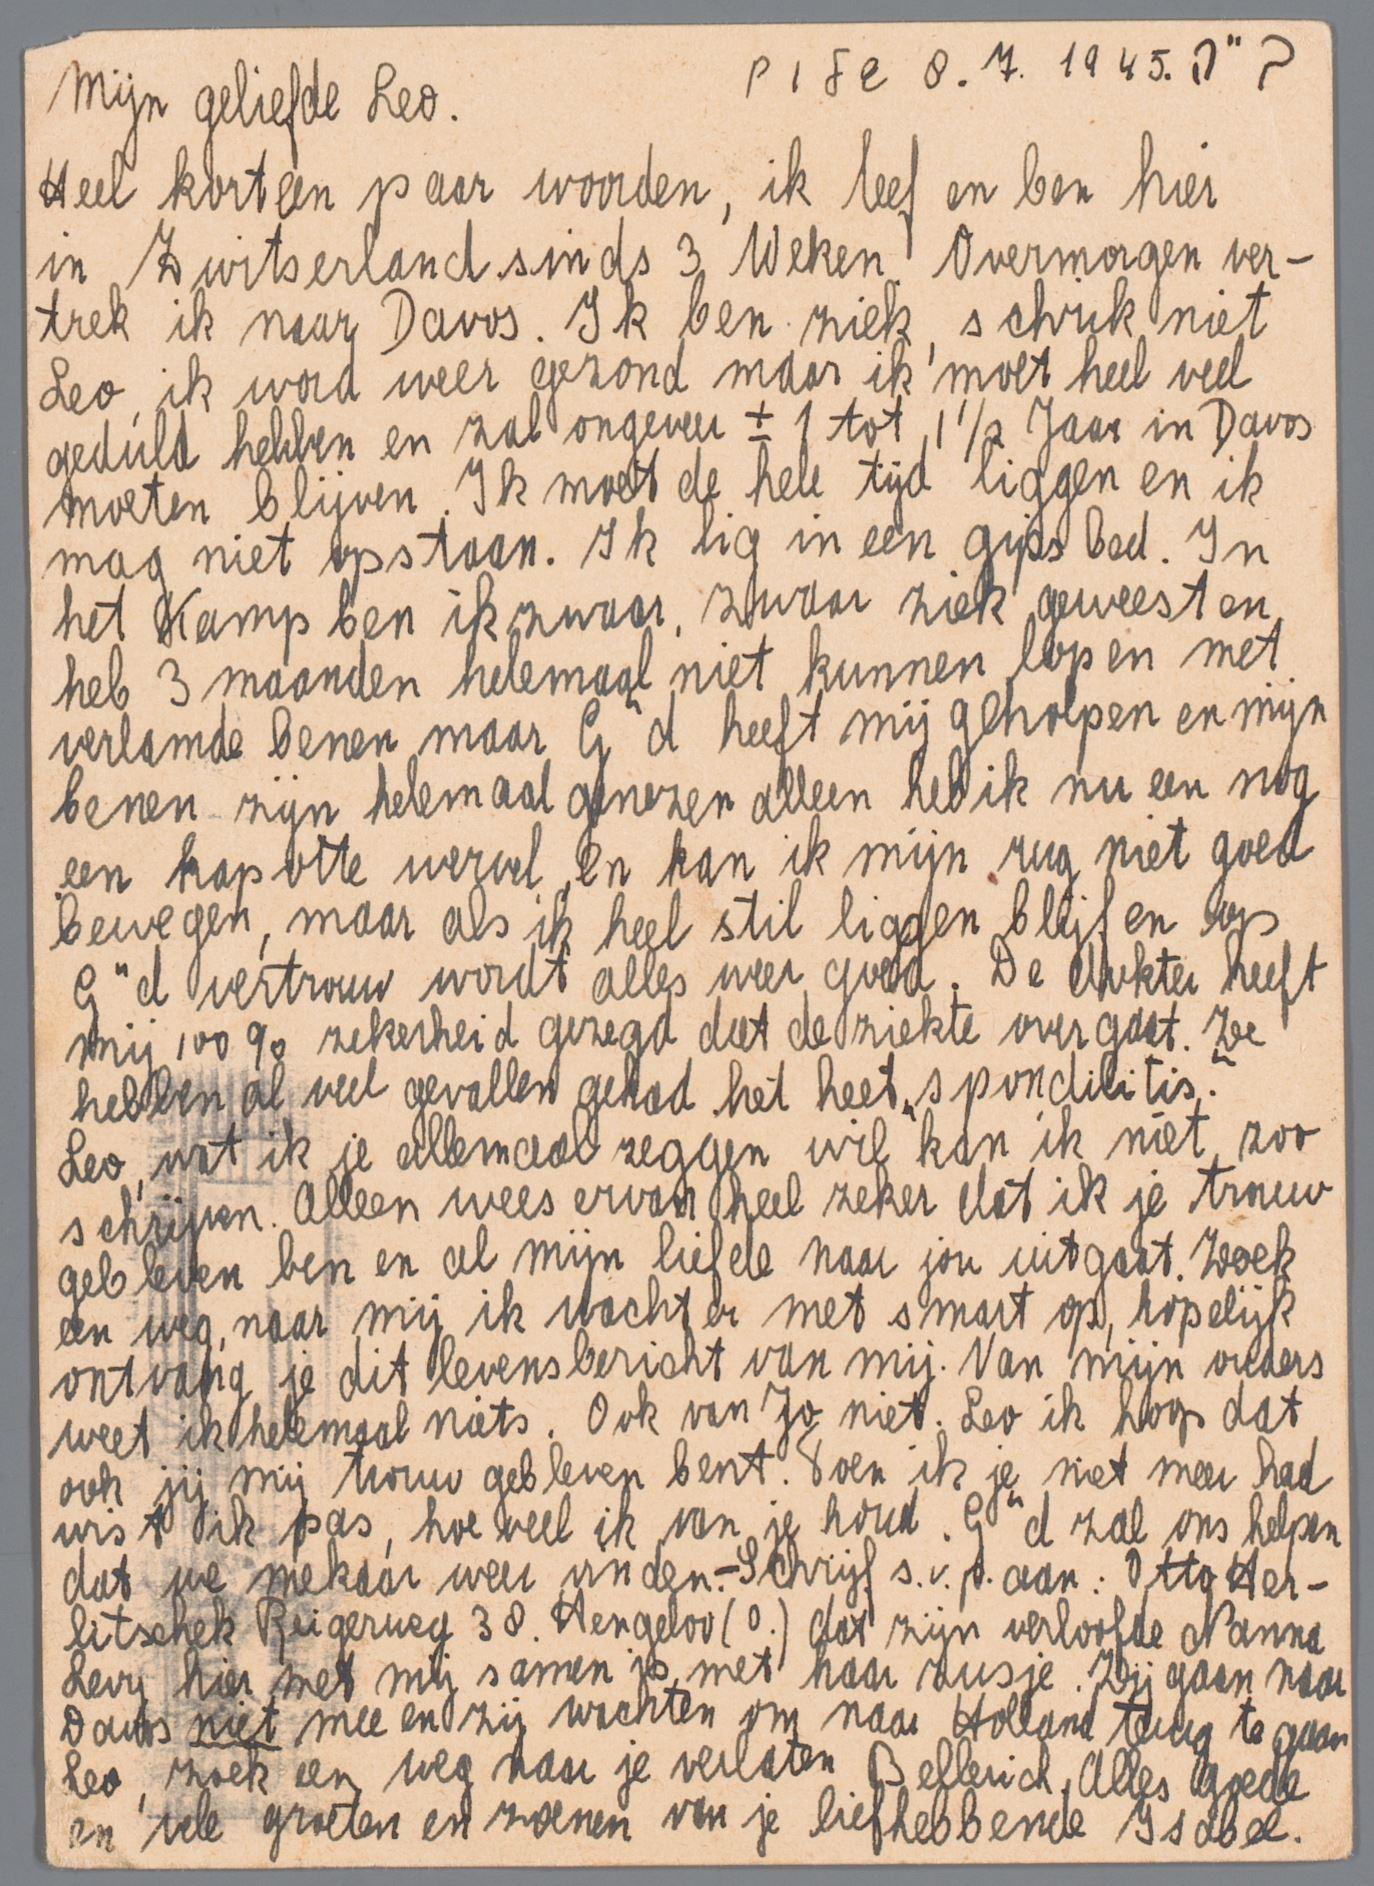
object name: letter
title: Belangrijke brieven met betrekking tot het leven van Isabel Wachenheimer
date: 1939-2002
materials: paper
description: Dit object is onderdeel van de nalatenschap van Isabel Elon-Wachenheimer (1928-2010). Tot haar overlijden behoorde het samen met de andere objecten uit de nalatenschap tot haar privédomein van Isabel Wachenheimer. In die particuliere context zijn deze objecten tezamen en individueel aandenkens - aan de jeugd, ouders en familie van Isabel Wachenheimer vóór en tijdens de Shoah en aan haar leven na de Tweede Wereldoorlog. Isabel Wachenheimer, die van juni 1943 tot mei 1945 gevangen zat in Kamp Westerbork, Theresienstadt, Auschwitz, Lenzing a/d Oberdonau (een buitenkamp van Mauthausen), overleefde de Shoah. Haar ouders – Eugène Wachenheimer en Else Wachenheimer-Moos - werden op 14 oktober 1944 in Auschwitz-Birkenau vermoord.